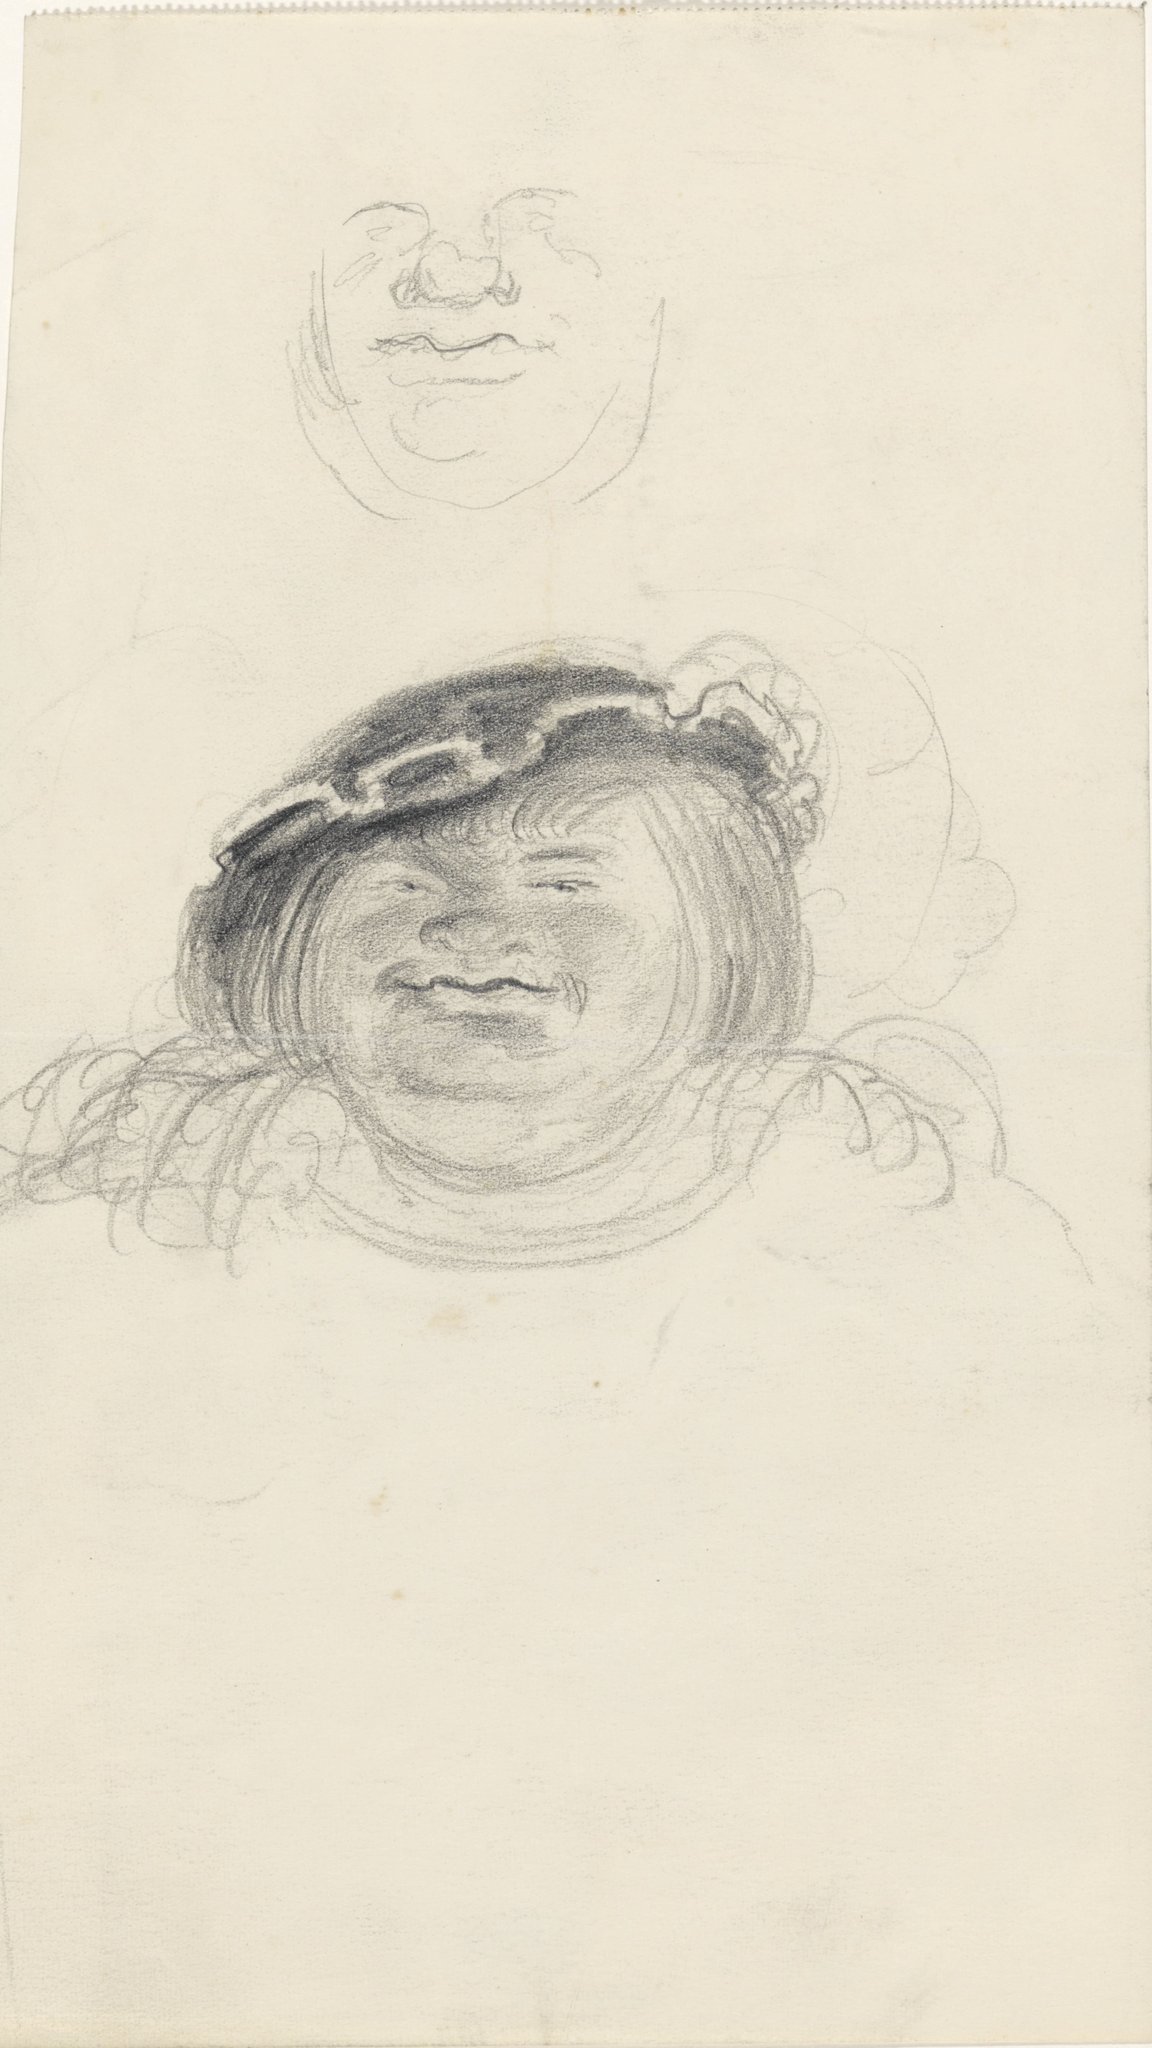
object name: drawing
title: Gezicht van een reus met baret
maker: henk henriët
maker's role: draughtsman, print maker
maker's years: 1903-1945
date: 1936-1940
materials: paper, pencil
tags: head-gear: beret, giants, colossi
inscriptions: collector's mark: Lugt 2228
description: Deze tekening is mogelijk een ontwerp voor een illustratie bij het boek 'Gargantua en Pantagruel' van François Rabelais.